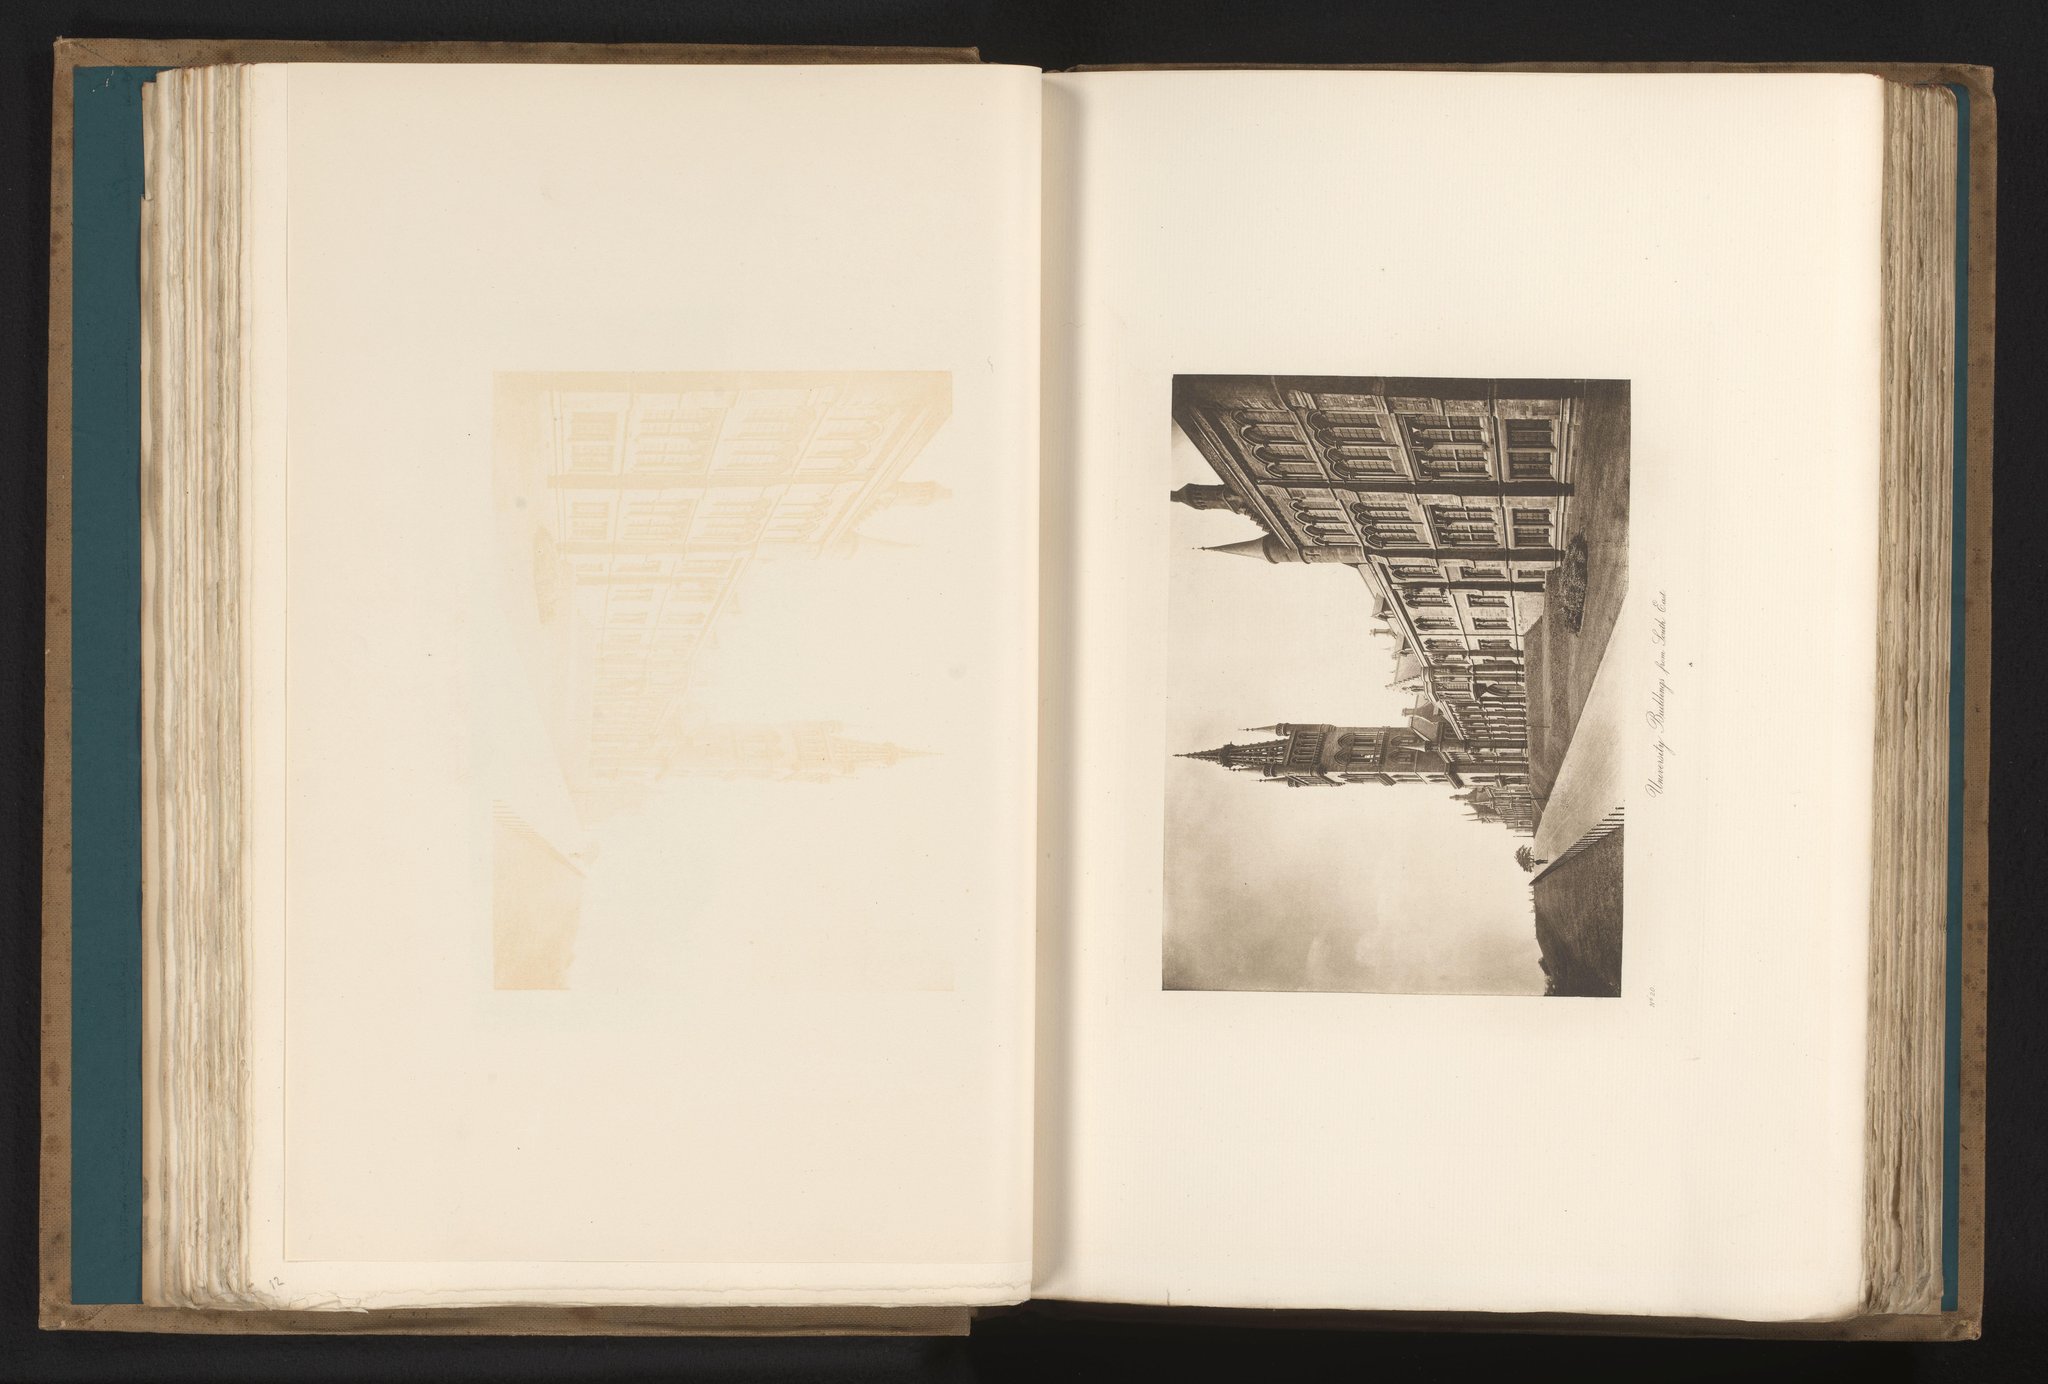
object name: photomechanical print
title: University Buildings from South East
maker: Anonymous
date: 1886-1891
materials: paper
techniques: photoaquatint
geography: glasgow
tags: university (+ building ~ education, tuition), street (+ city(-scape) with figures, staffage), glasgow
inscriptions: inscription: ‘No.20’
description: Prent op zesde ongenummerde pagina na pagina xxxiii.